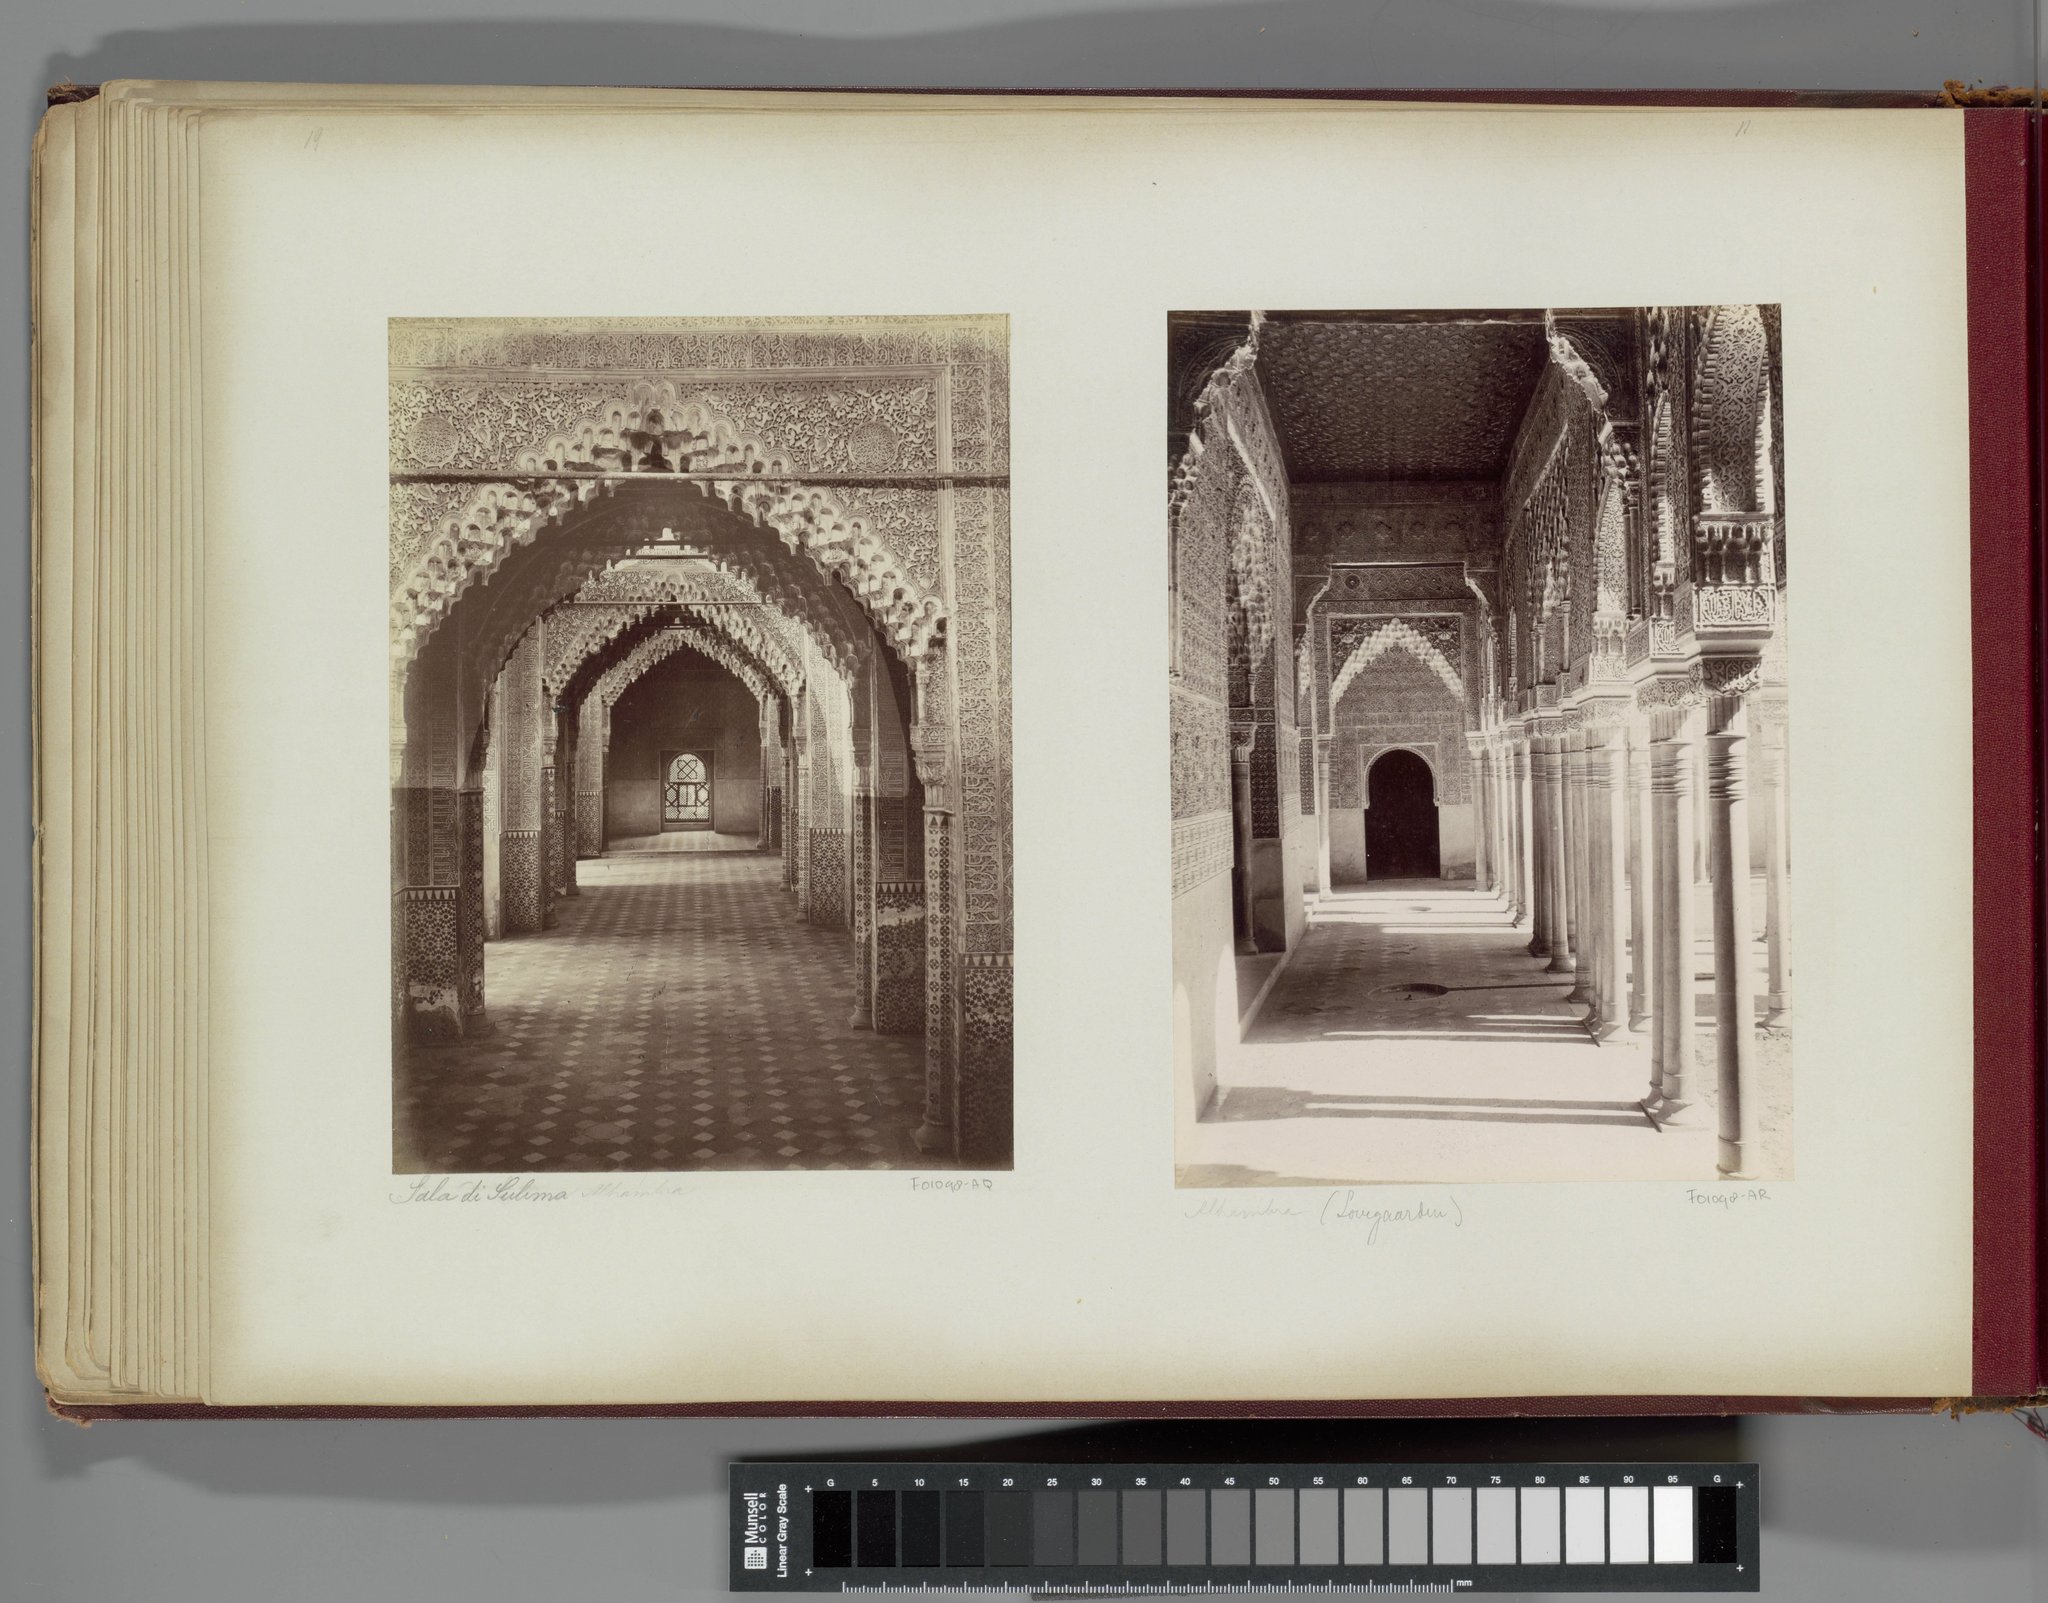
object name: photograph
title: Sala de los Reyes in het Alhambra in Granada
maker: Anonymous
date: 1860-1880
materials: cardboard, paper, photographic support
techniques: albumen print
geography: alhambra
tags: palace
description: Onderdeel van Reisalbum met foto's van bezienswaardigheden in Spanje en Marokko.